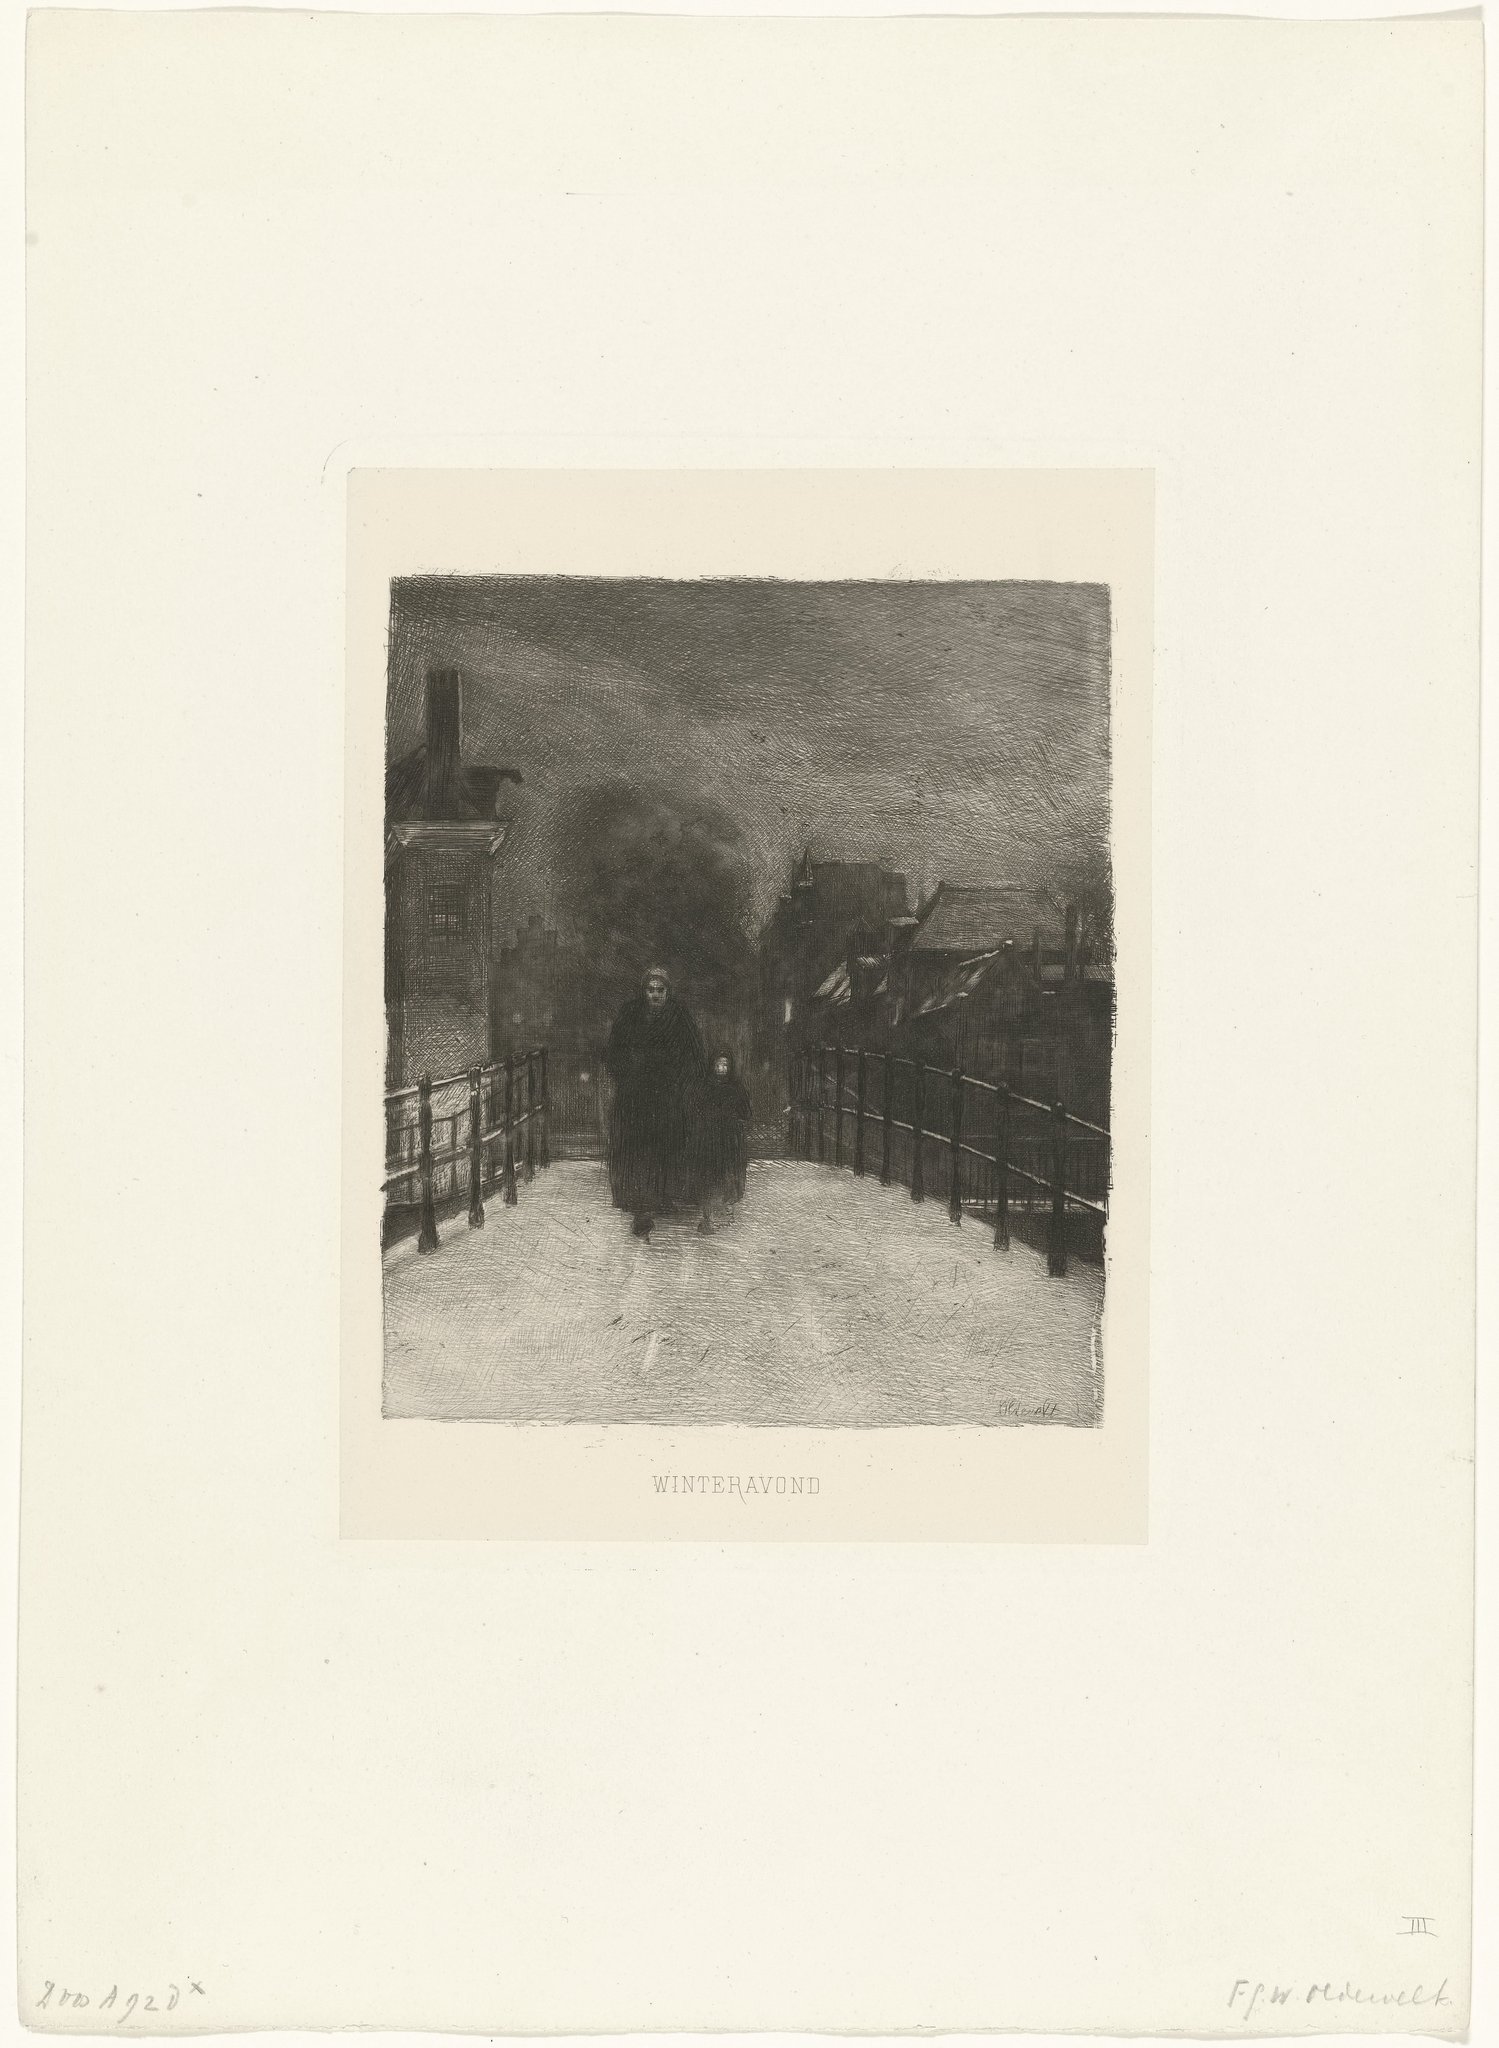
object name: print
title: Winteravond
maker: ferdinand oldewelt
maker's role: draughtsman, print maker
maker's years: 1857-1935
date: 1888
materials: paper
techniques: drypoint, etching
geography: netherlands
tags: frost, freezing weather, old woman, the poor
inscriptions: collector's mark: Lugt 2760, collector's mark: Lugt 2228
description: Wintergezicht met een oude vrouw en een kind die over een brug lopen. Waarschijnlijk de brug op de hoek van de Spiegelgracht en de Lijnbaansgracht in Amsterdam.